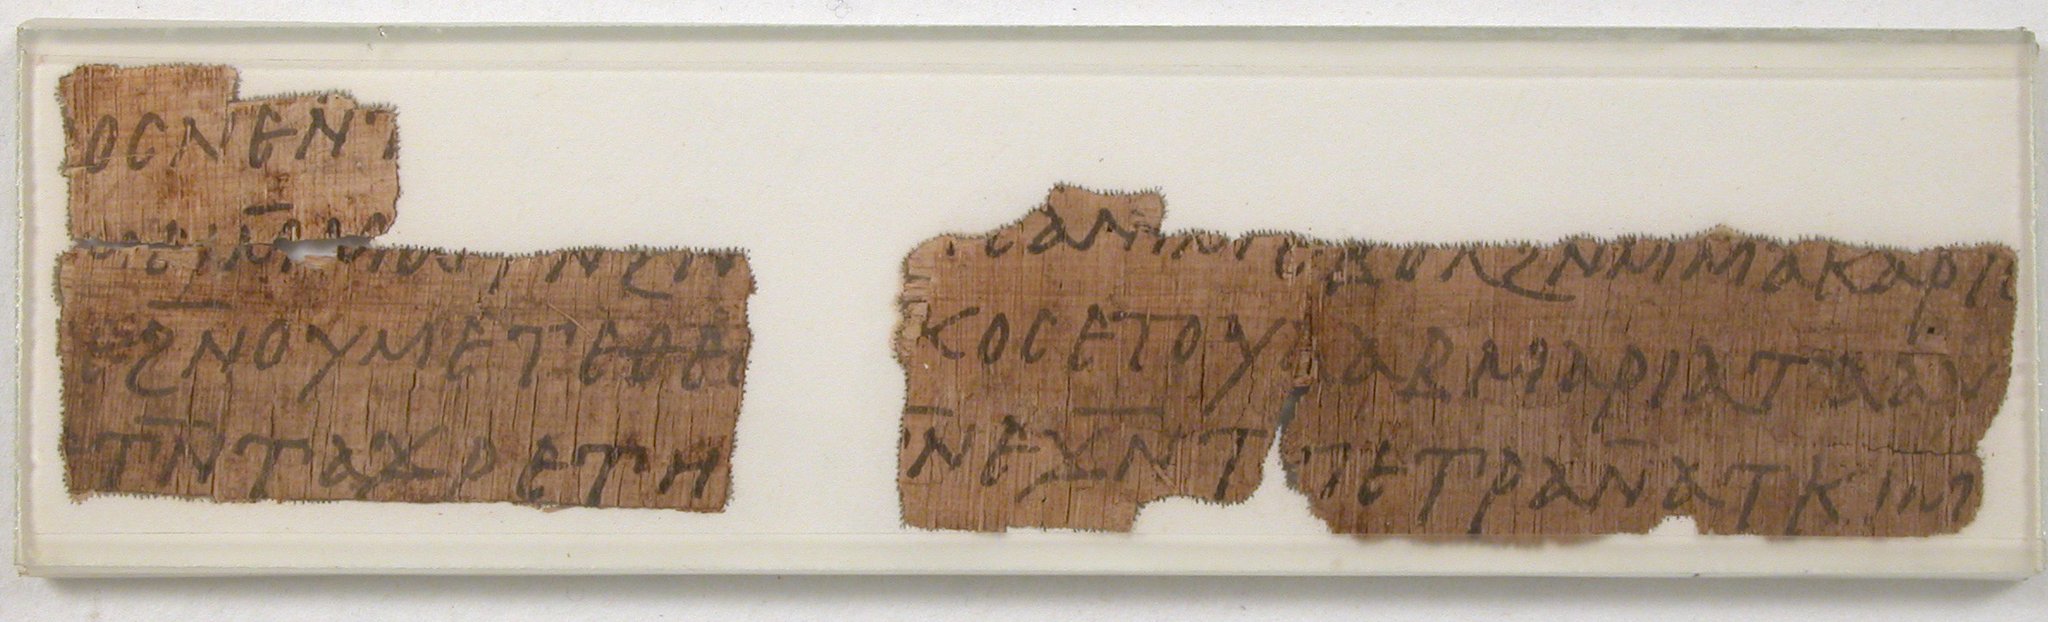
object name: fragment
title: Papyrus Fragments of a Letter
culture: coptic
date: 601-700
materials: ink, papyrus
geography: egypt